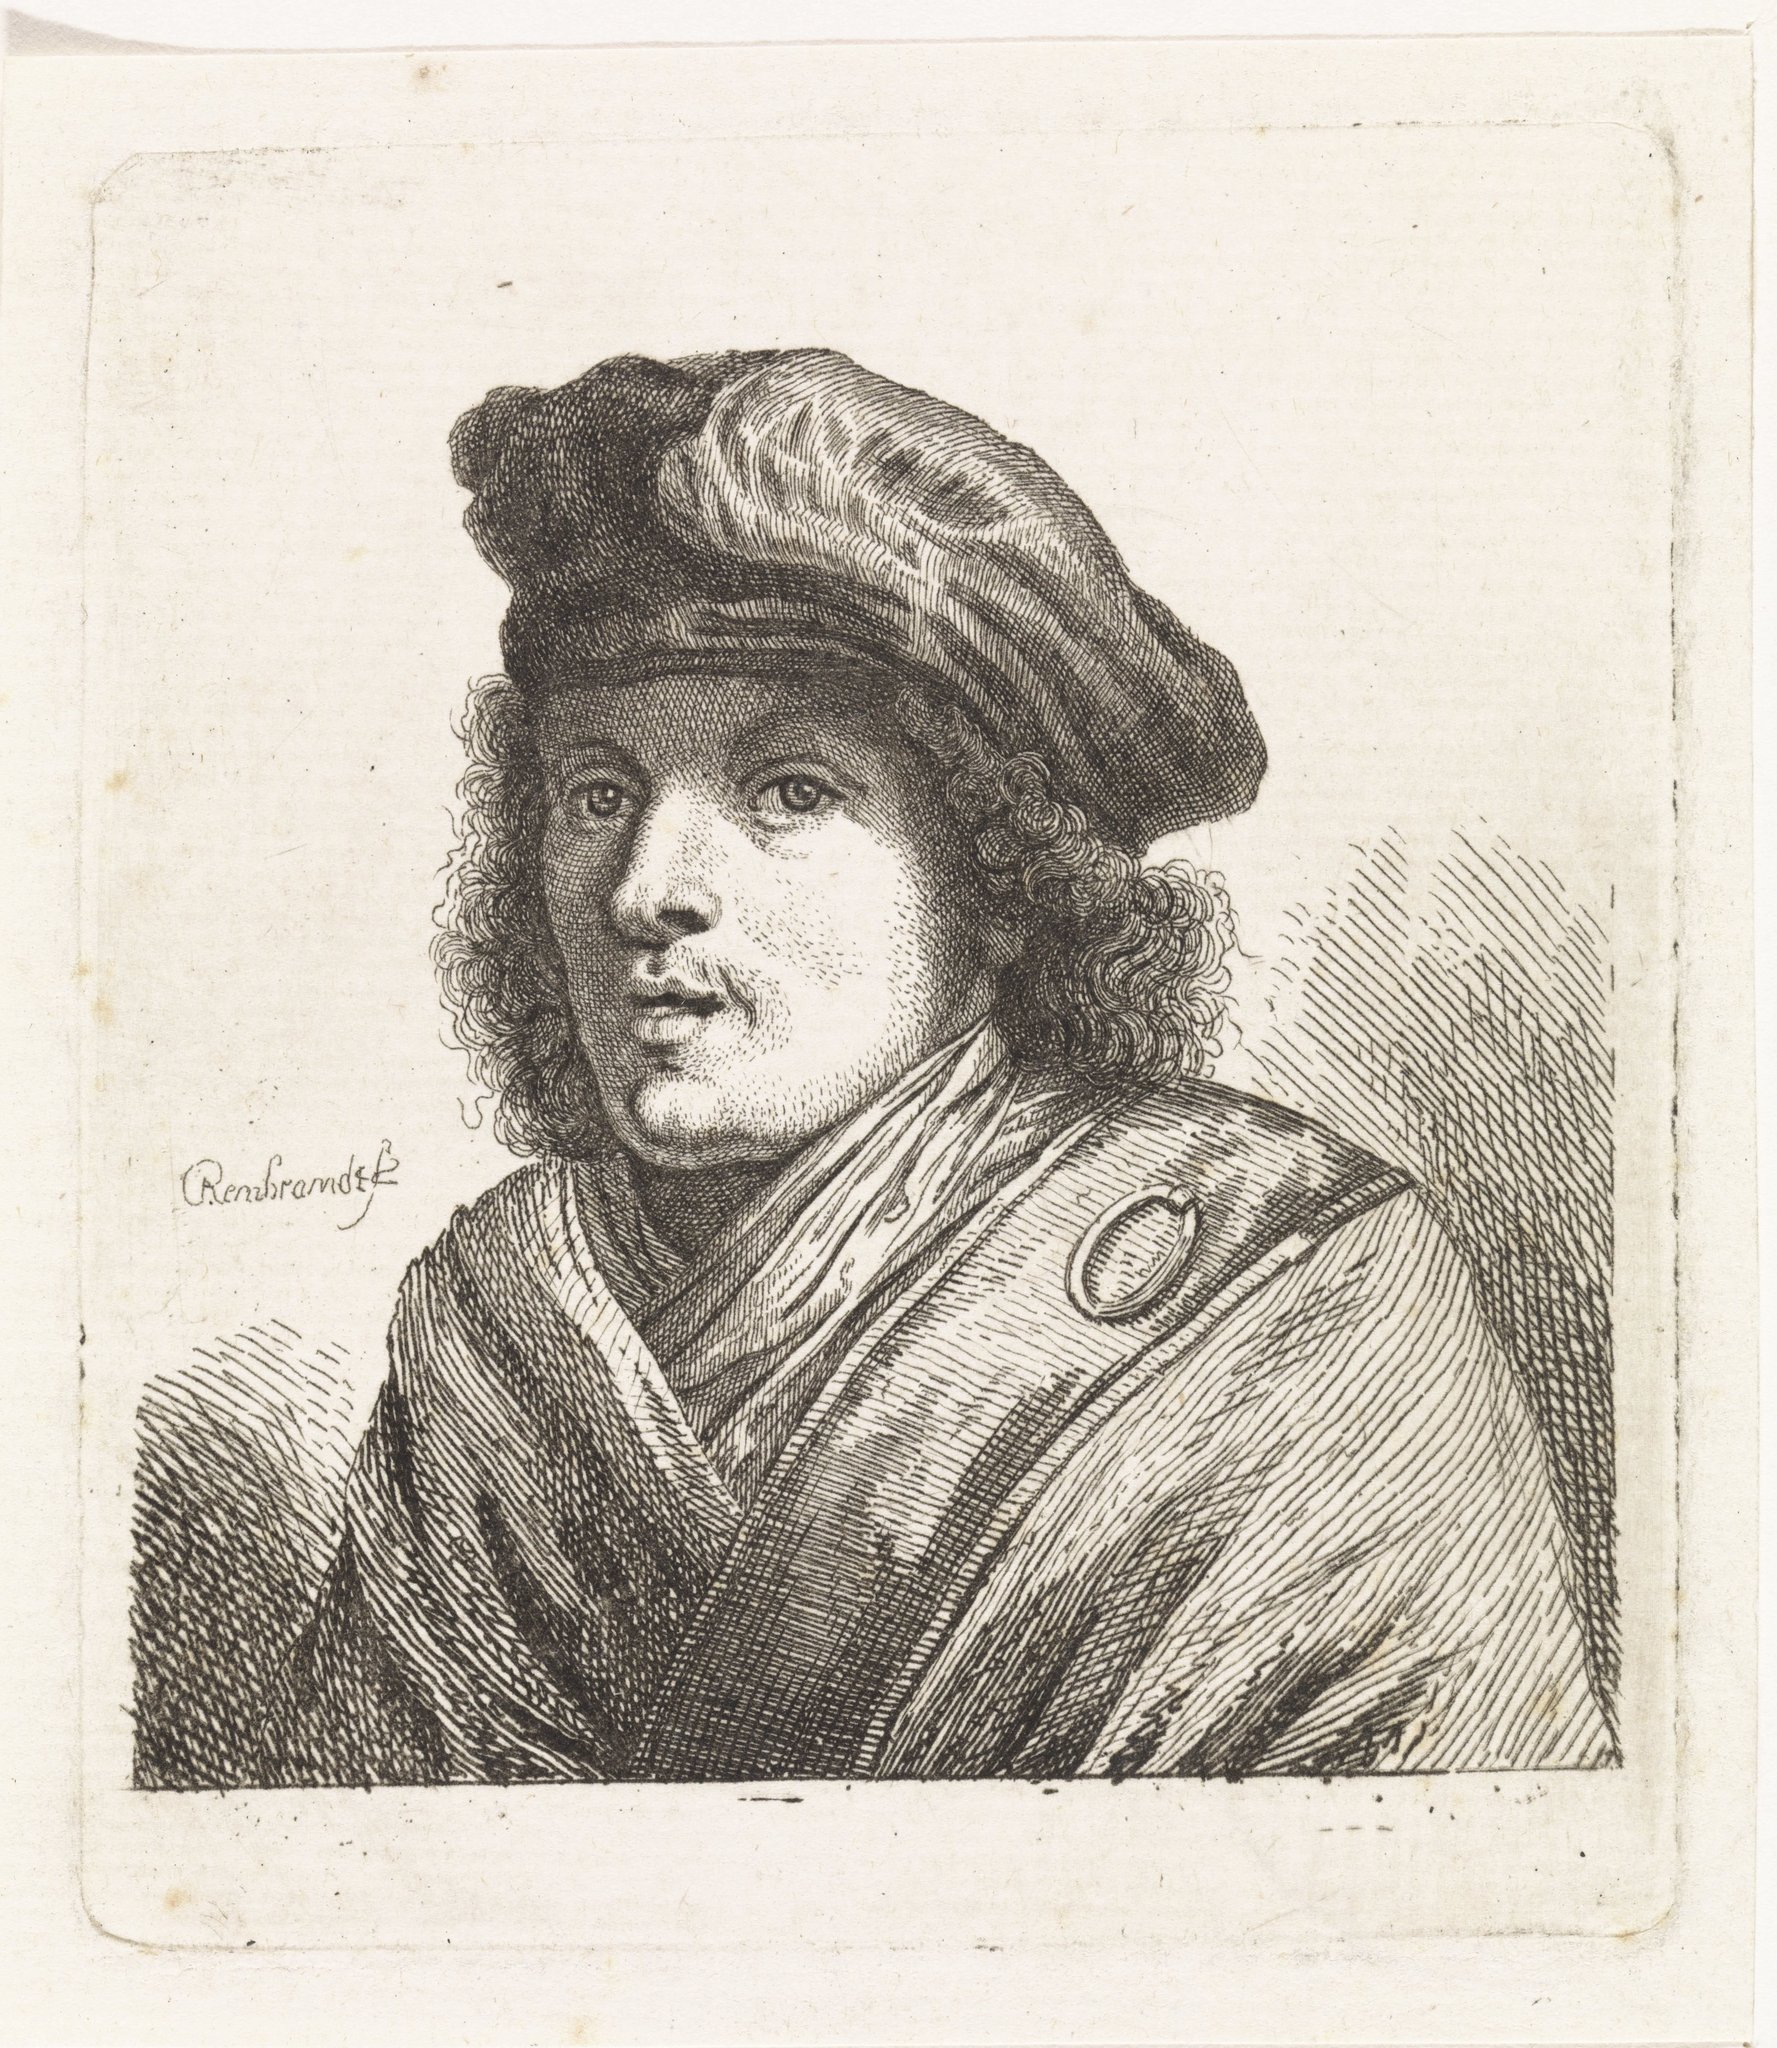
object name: print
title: Portret van Rembrandt van Rijn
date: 1696-1727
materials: paper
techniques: etching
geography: amsterdam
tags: leiden, painter, draughtsman, rembrandt van rijn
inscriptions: collector's mark: Lugt 240